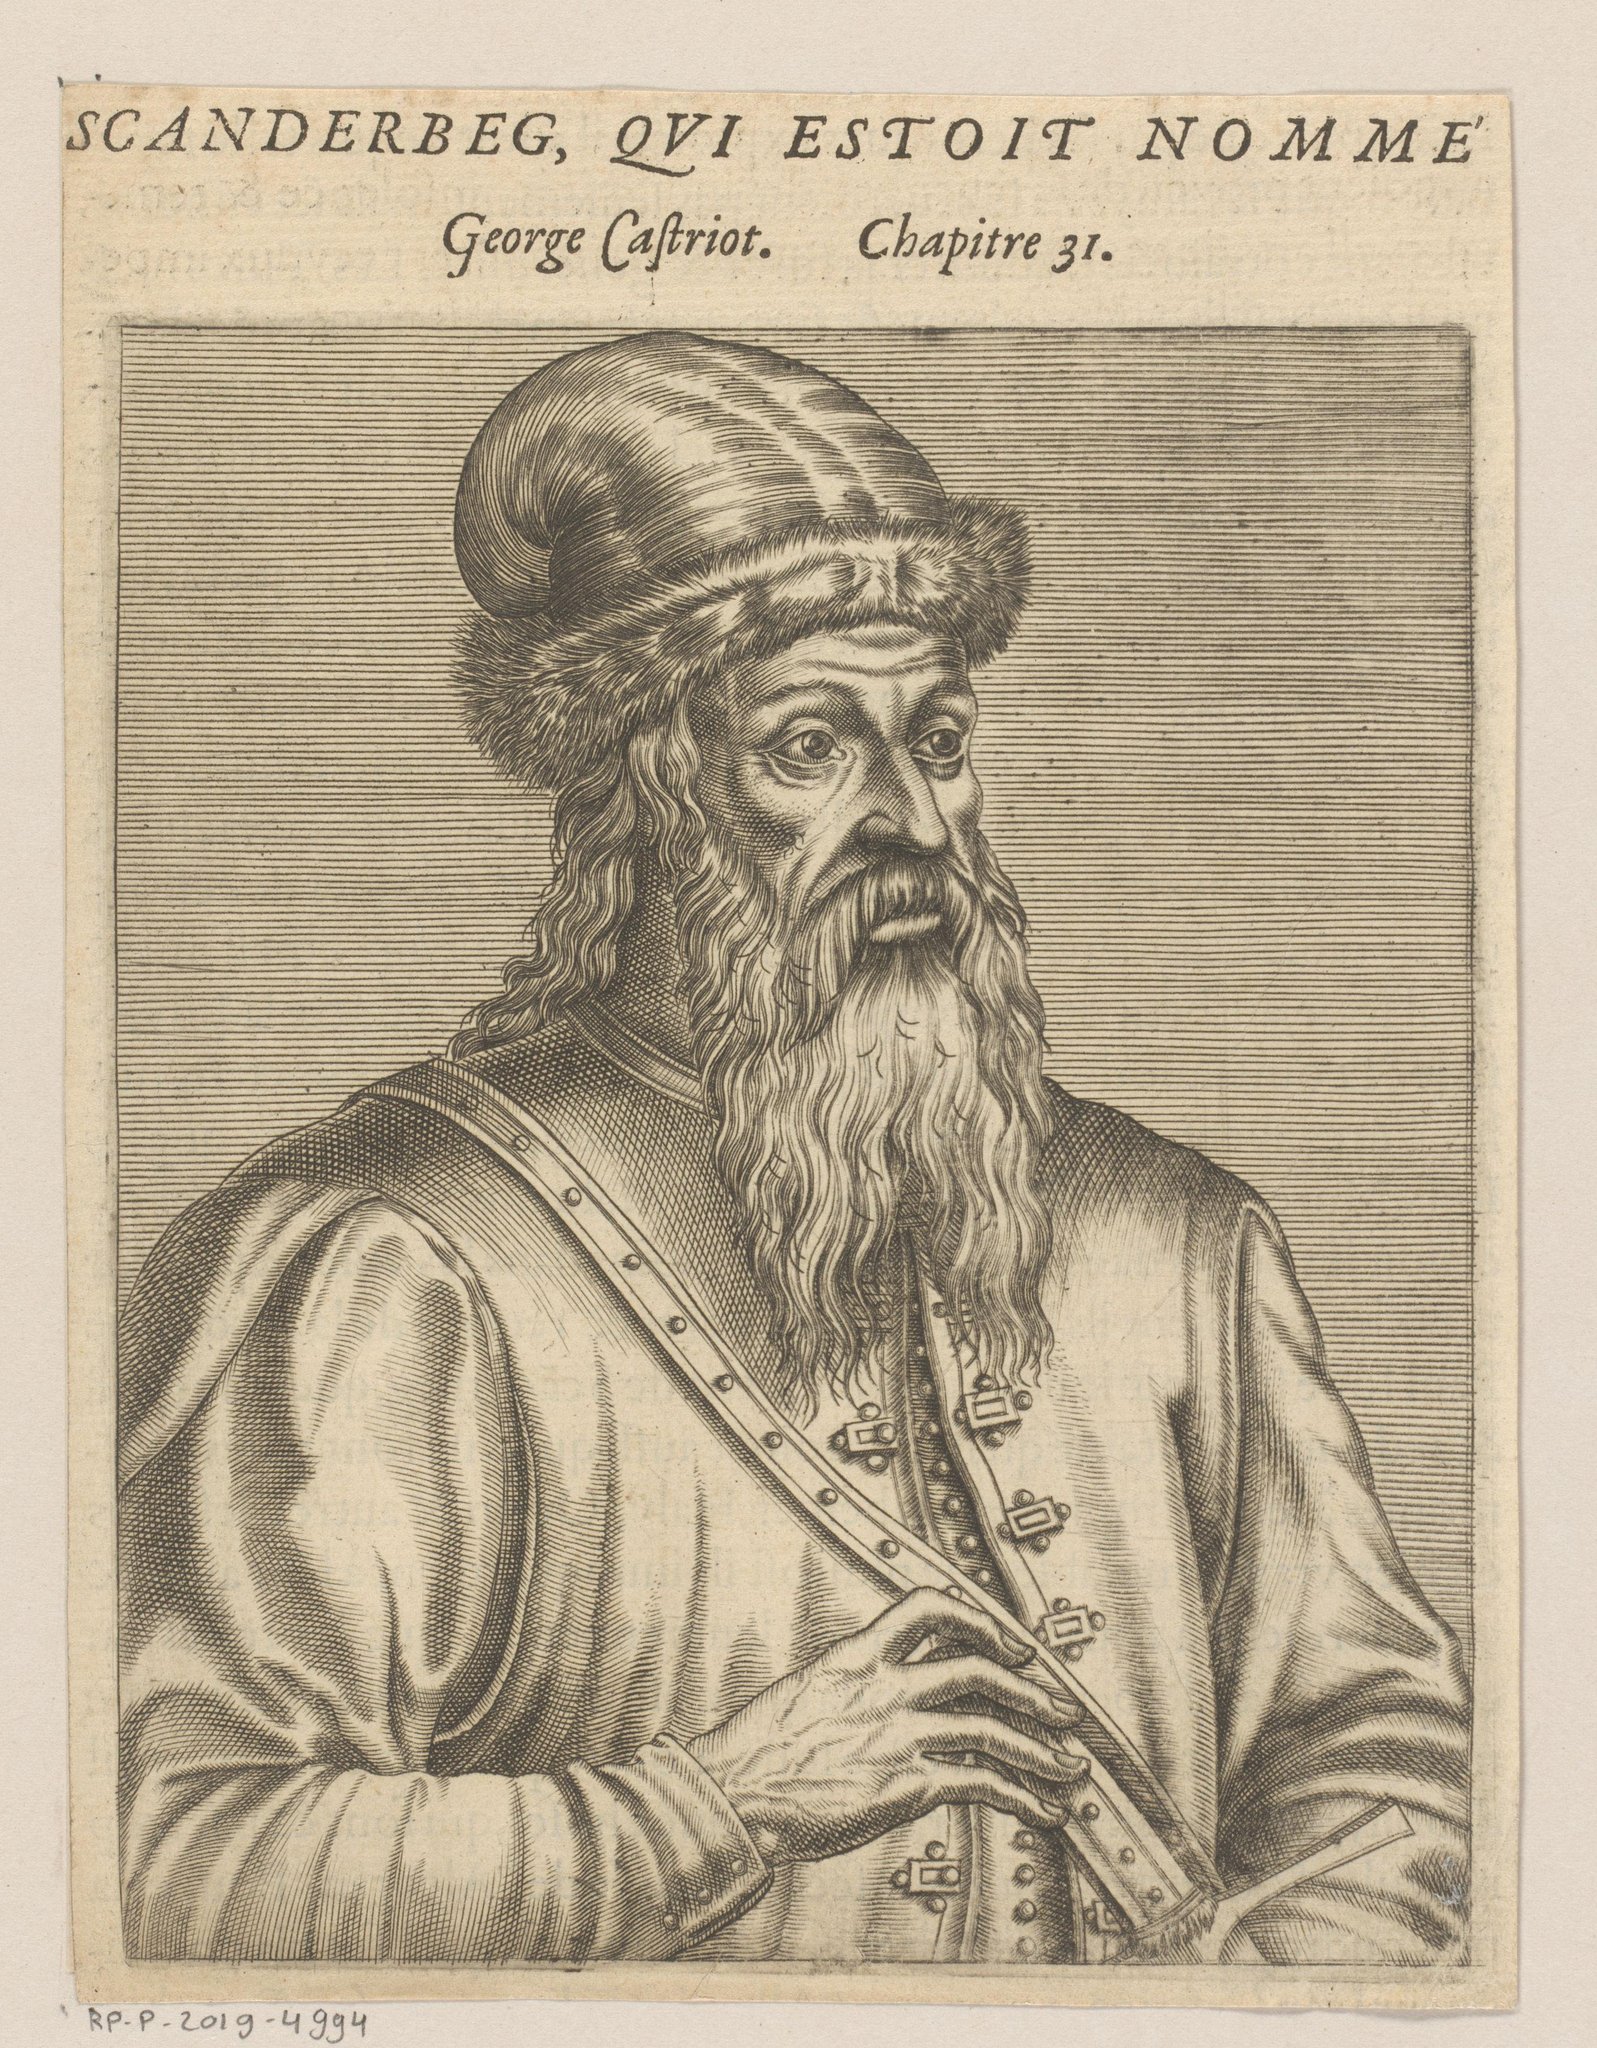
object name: book illustration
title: Portret van Skanderbeg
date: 1584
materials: paper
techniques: engraving, letterpress printing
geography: paris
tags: historical persons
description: Prent uit: Thevet, André. Les vrais pourtraits et vies des hommes illustres grecz, latins et payens (...). Parijs: weduwe Jacques Kerver en Guillaume Chaudière, 1584, dl. 2, f. 304.